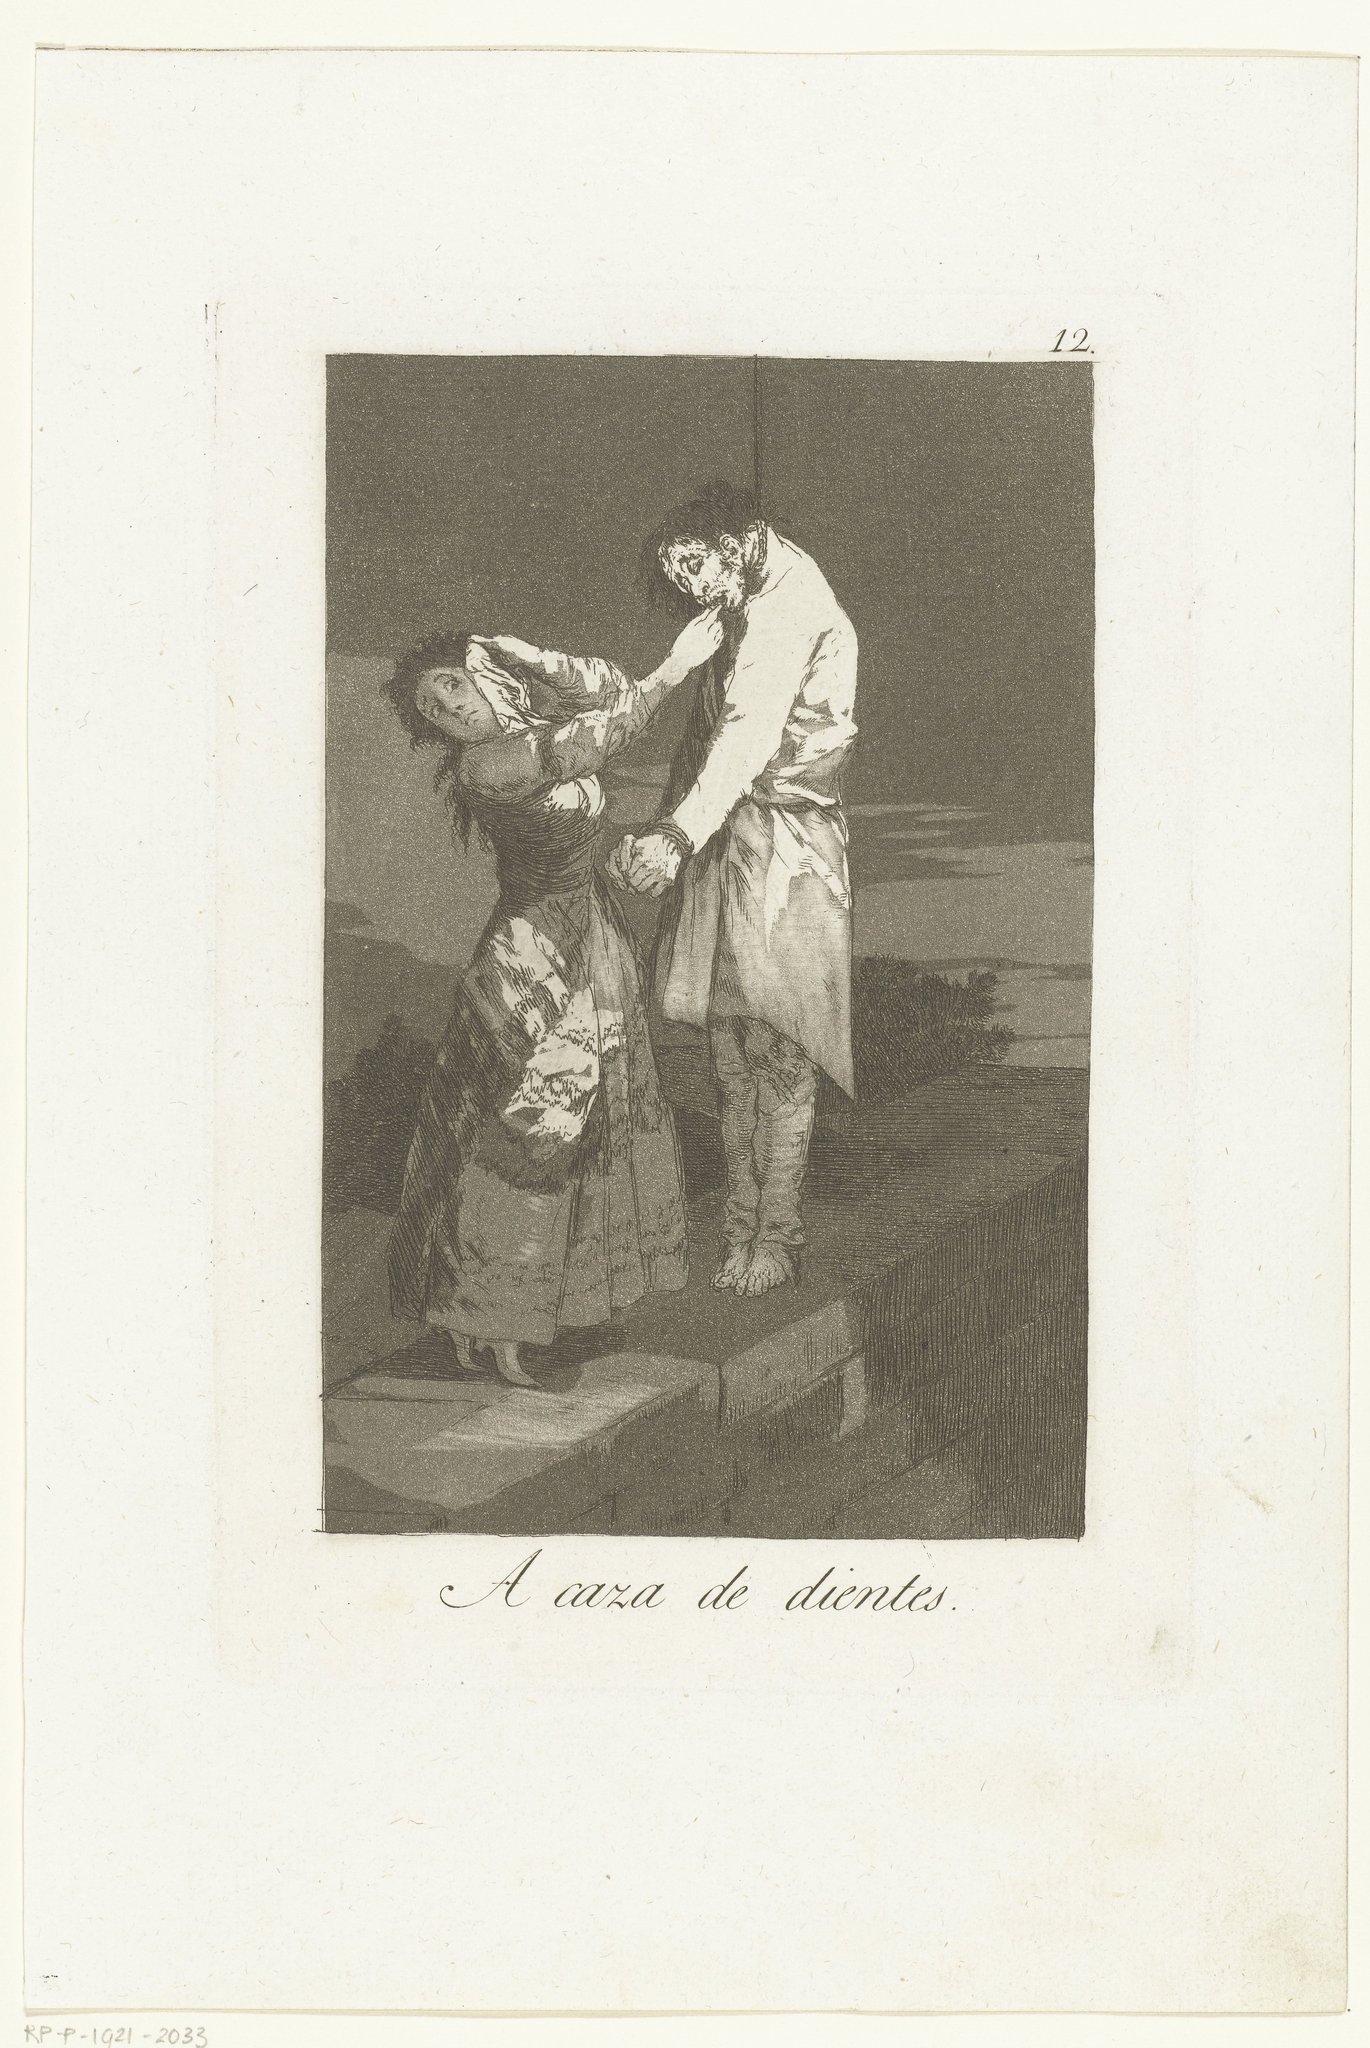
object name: print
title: Los Caprichos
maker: francisco de goya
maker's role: draughtsman, painter, print maker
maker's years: 1746-1828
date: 1797-1799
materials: paper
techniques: aquatint, etching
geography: spain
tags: violent death by hanging, quack extracting teeth or molars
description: Een vrouw, met haar hoofd afgewend en aftgeschermd met een zakdoek, probeert de tanden uit de mond van een opgehangen man te trekken. Twaalfde prent uit de serie Los Caprichos.